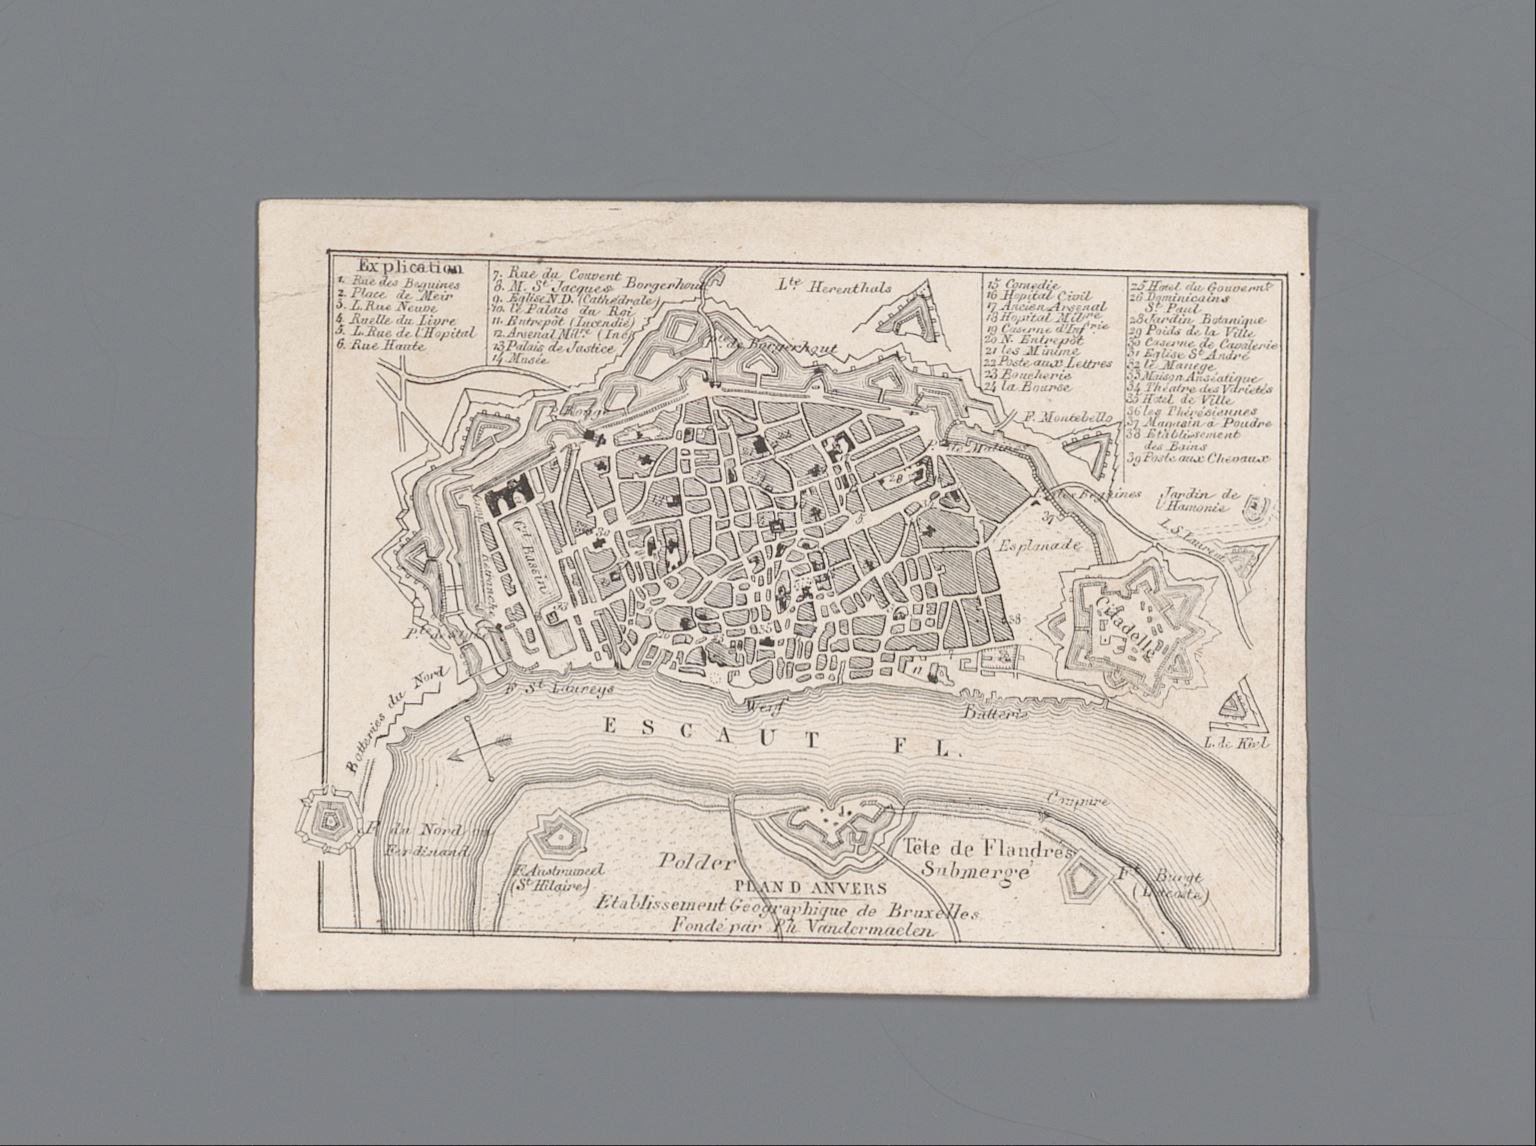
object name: print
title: Plan D Anvers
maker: philippe vandermaelen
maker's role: cartograaf, geograaf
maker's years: 1795-1869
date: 1805-1869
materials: paper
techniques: lithograph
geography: brussels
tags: maps of cities, antwerp